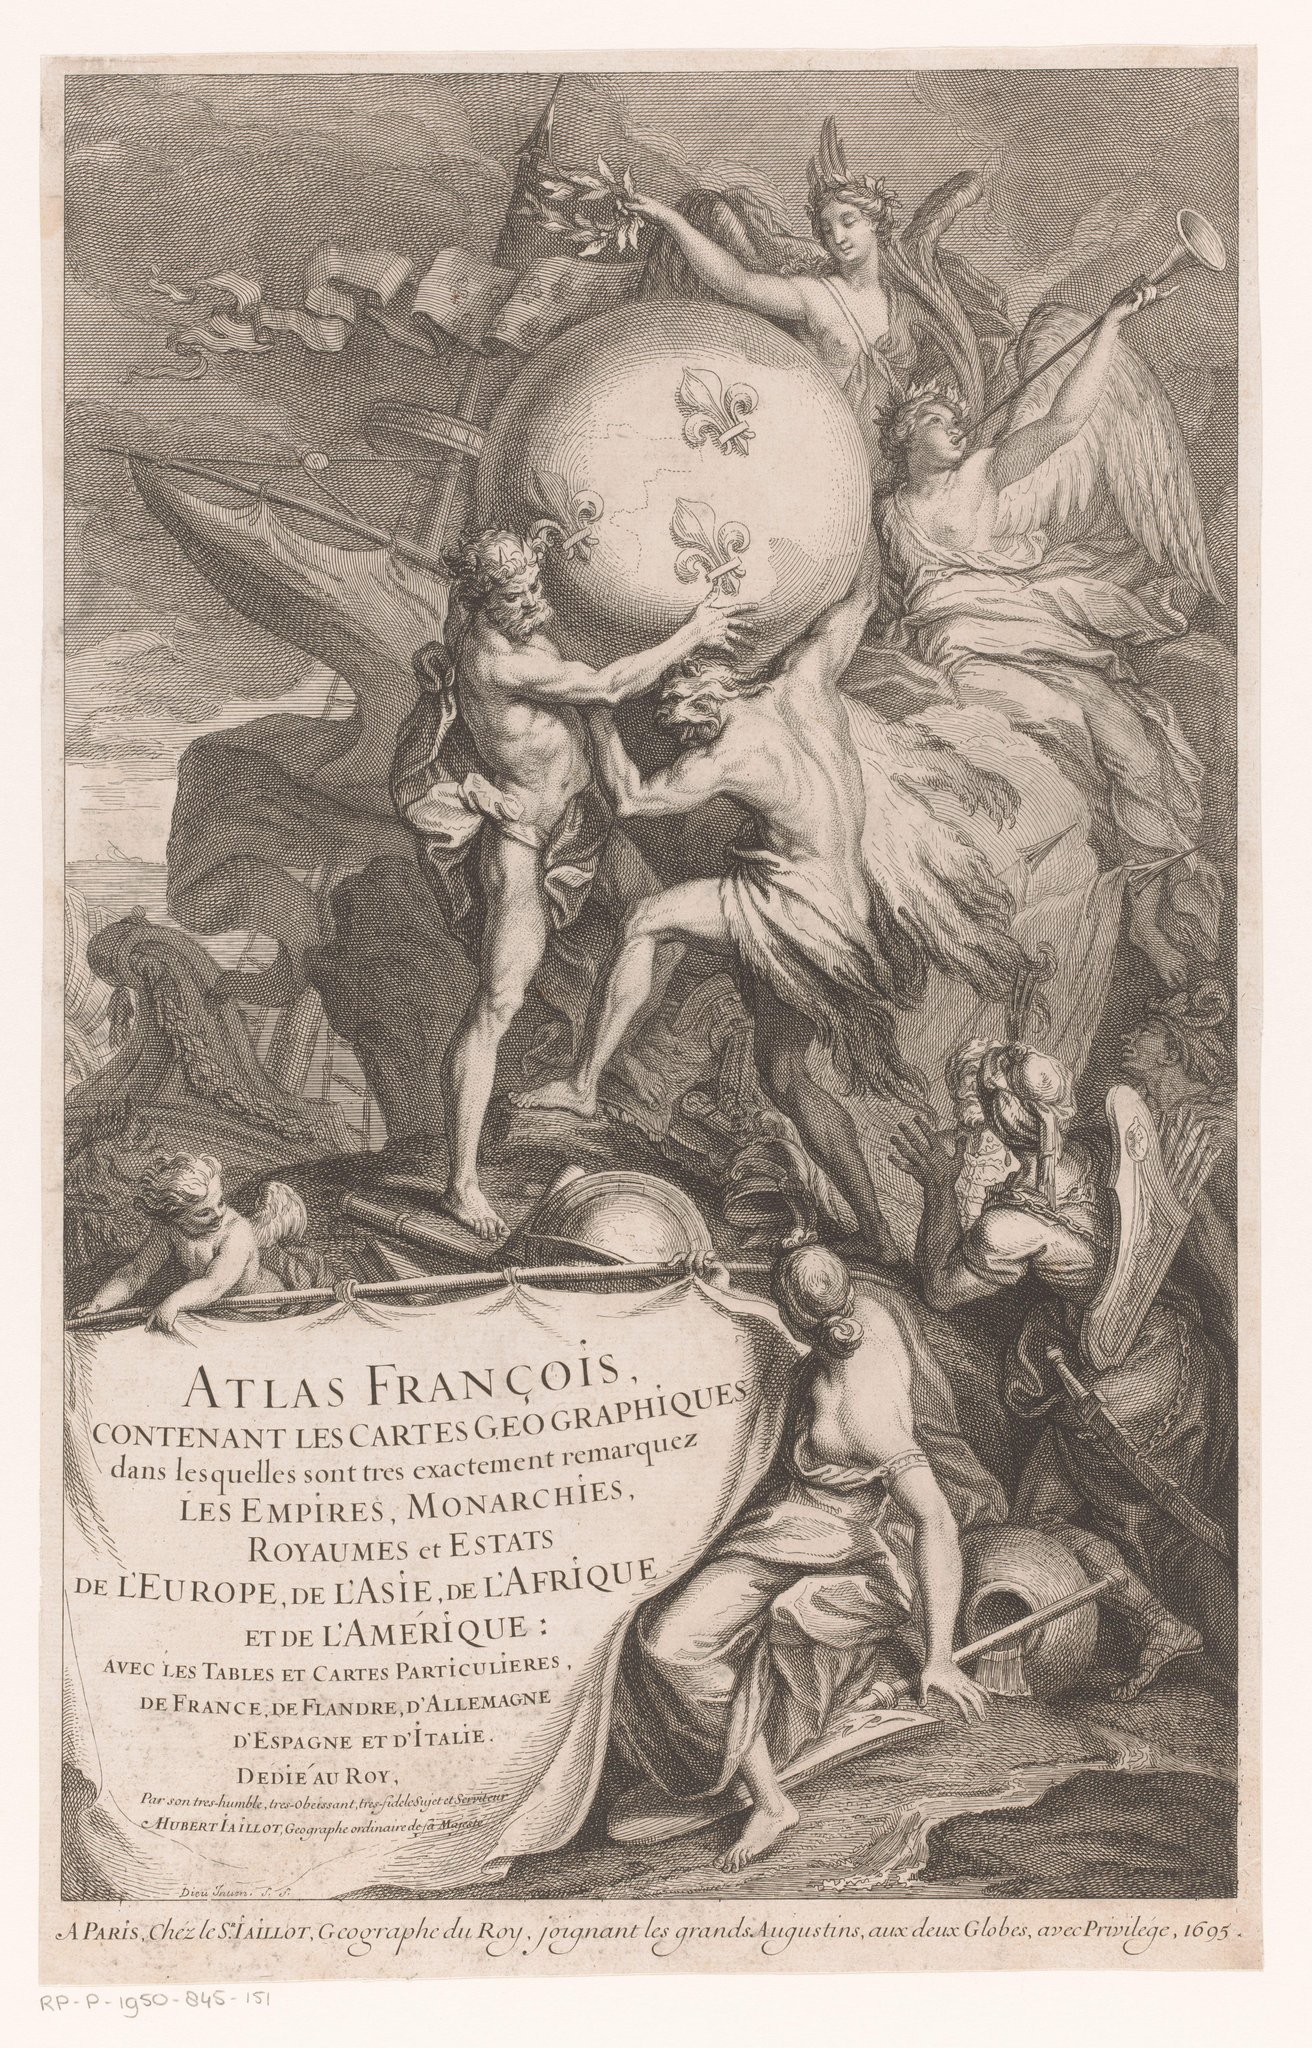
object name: titelblad, titelpagina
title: Hercules plaatst een globe op de schouders van Atlas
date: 1695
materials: paper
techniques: engraving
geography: paris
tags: (story of) hercules (heracles), (story of) atlas, globe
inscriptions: collector's mark: Lugt 2228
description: Titelpagina voor: Jaillot, Hubert. Atlas François, contenant les Cartes Geographiques dans lequelles sont tres exactement remarquez les Empires, Monarchies, Royaumes et Estats de l'Europe, de l'Asie, de l'Afrique et de l'Amerique (...). Parijs: Jaillot, Hubert, 1695. Prent afkomstig uit een plakalbum met titelprenten, ornamenten etc. op blauw papier in 1983 uit elkaar gehaald. Volgens een notitie op verso zat de prent op p. 151 van dit album.